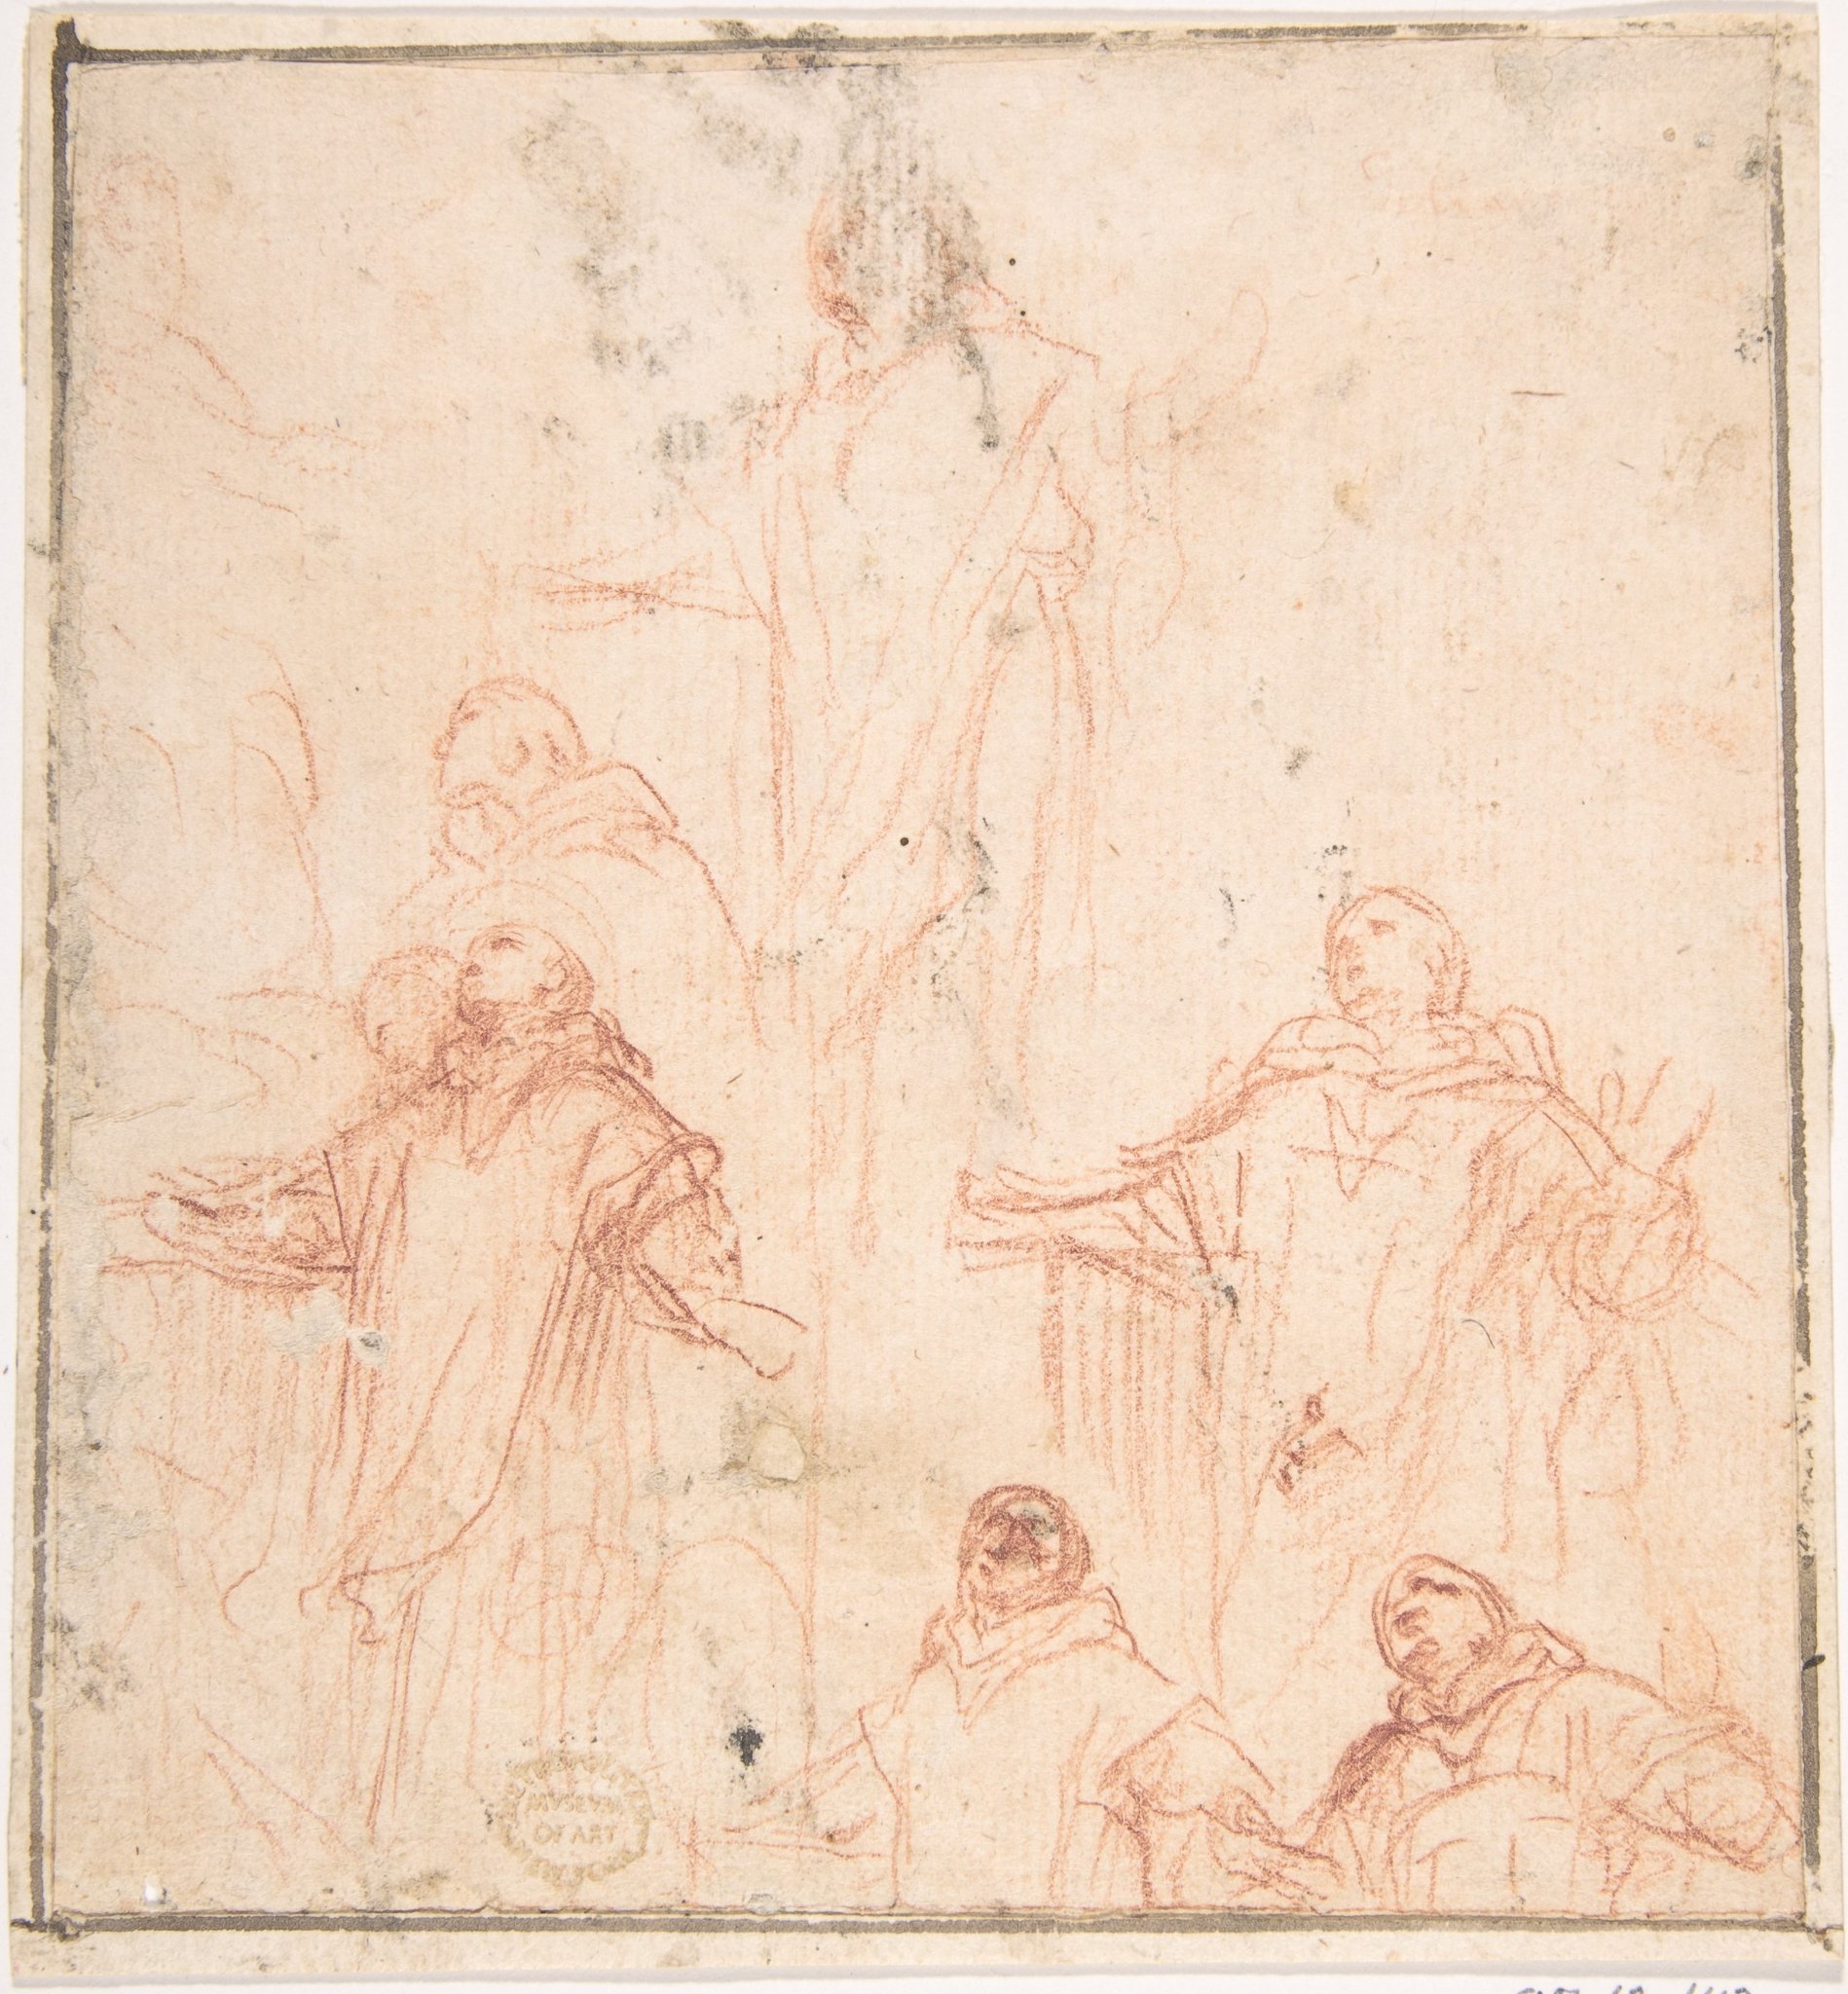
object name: drawing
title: Studies of a Monk in Ecstasy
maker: anonymous, italian, roman-bolognese, 17th century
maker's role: artist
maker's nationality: italian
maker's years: 1600-1700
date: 1601-1700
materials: chalk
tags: monks